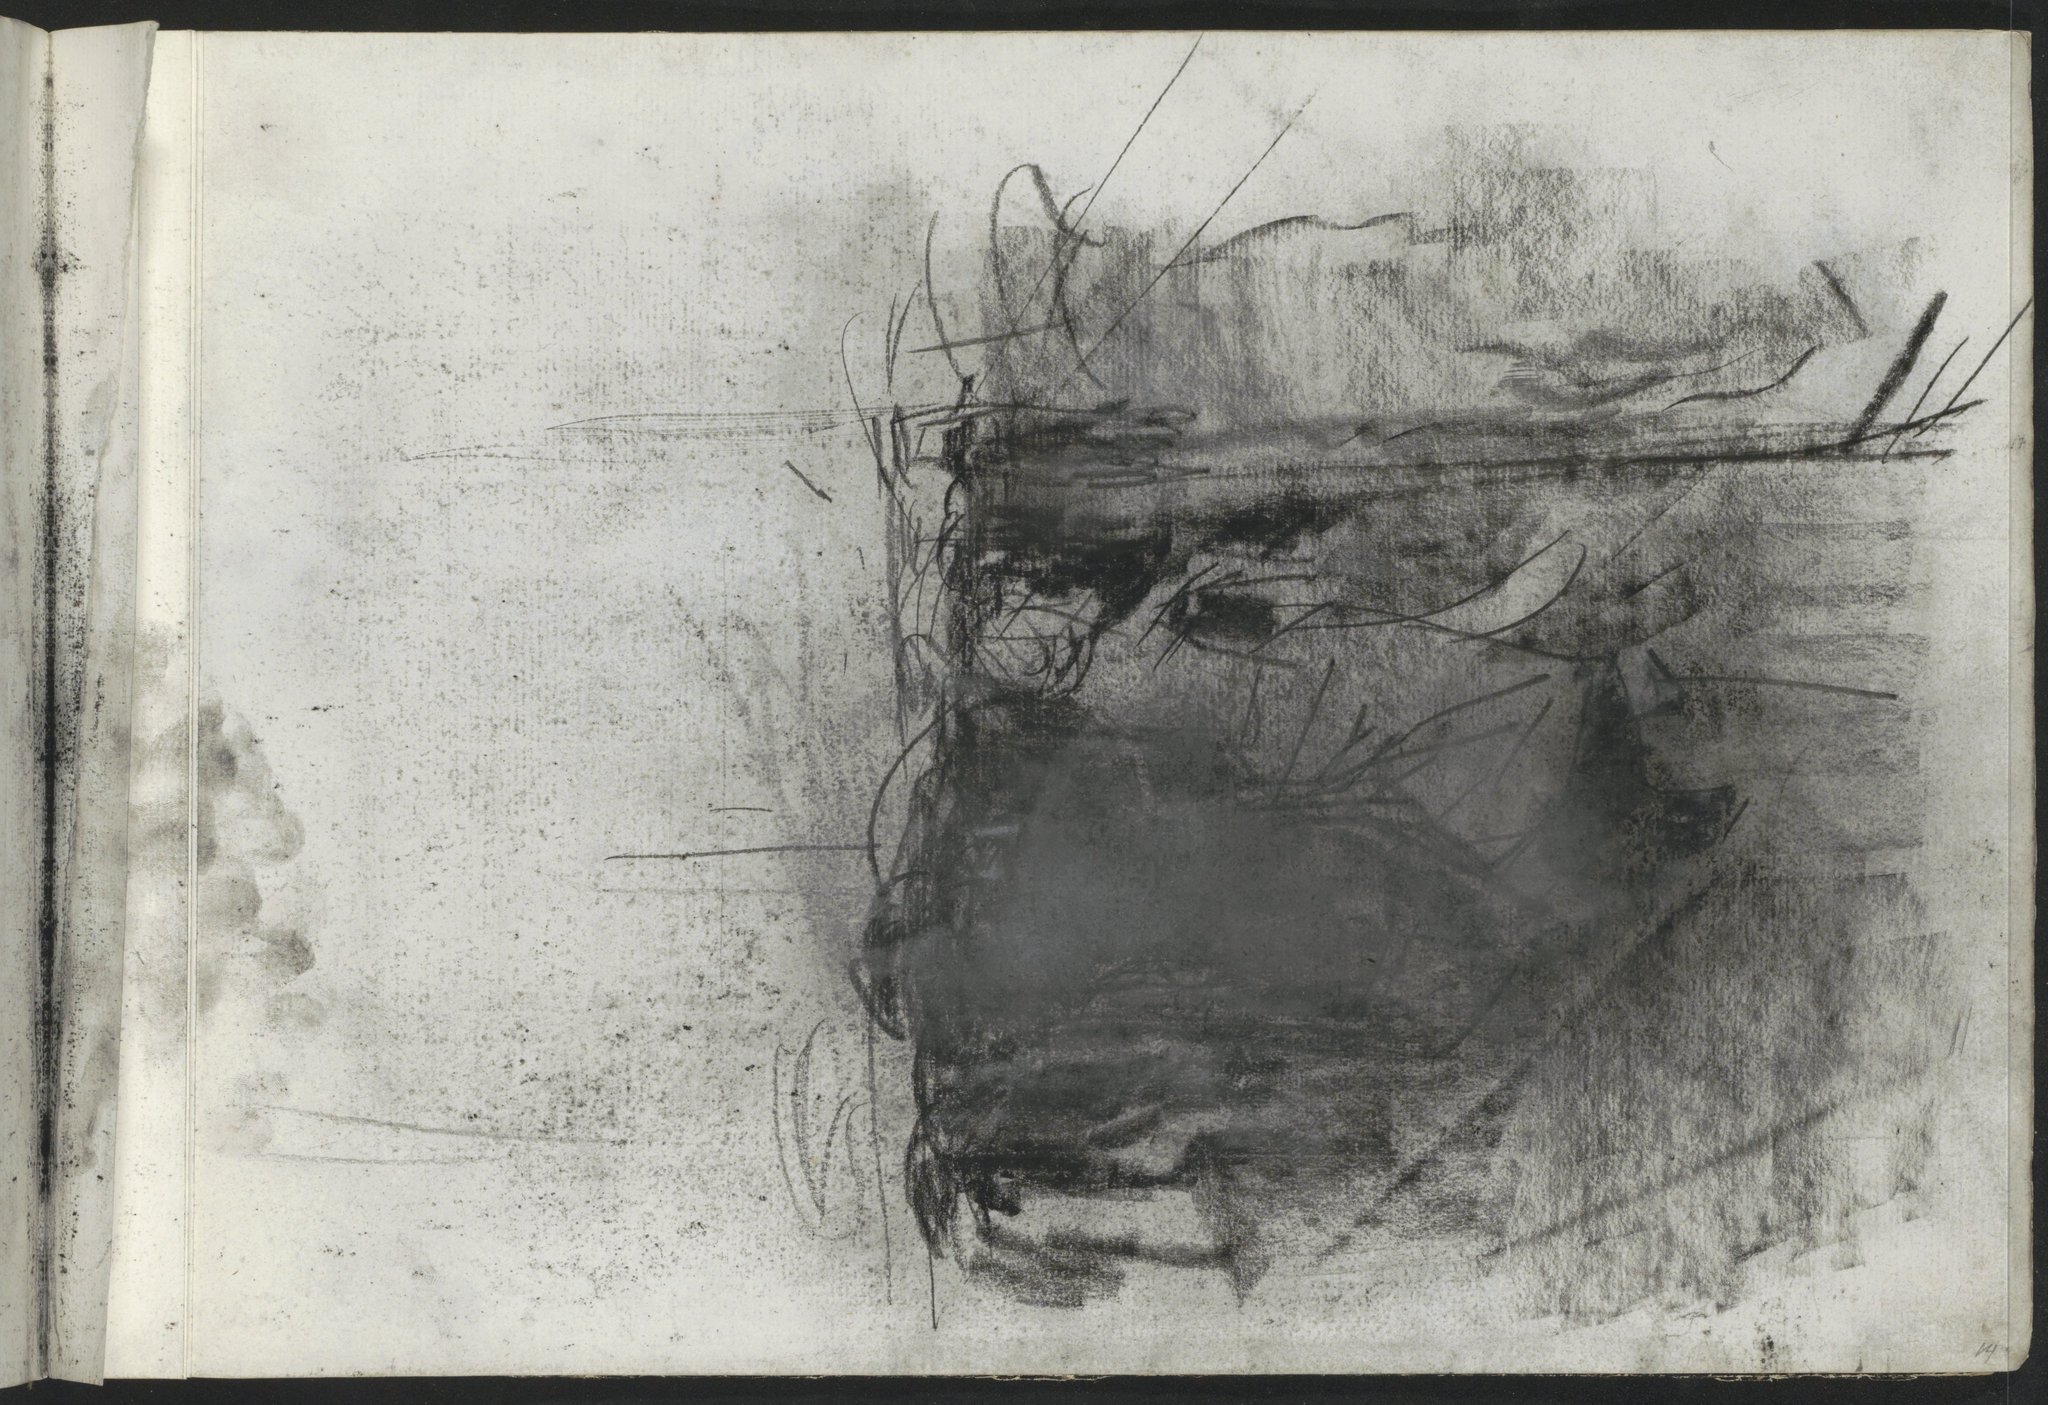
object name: sketchbook leaf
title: Figuren op straat, bij regen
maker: isaac israels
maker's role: draughtsman, painter, print maker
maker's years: 1865-1934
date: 1886-1934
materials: chalk, paper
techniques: stumping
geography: amsterdam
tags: adult woman (+ back view), rain, street (+ city(-scape) with figures, staffage)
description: Vooraan een vrouw die haar rok optilt. Blad 14 recto uit schetsboek LXX met 17 bladen.